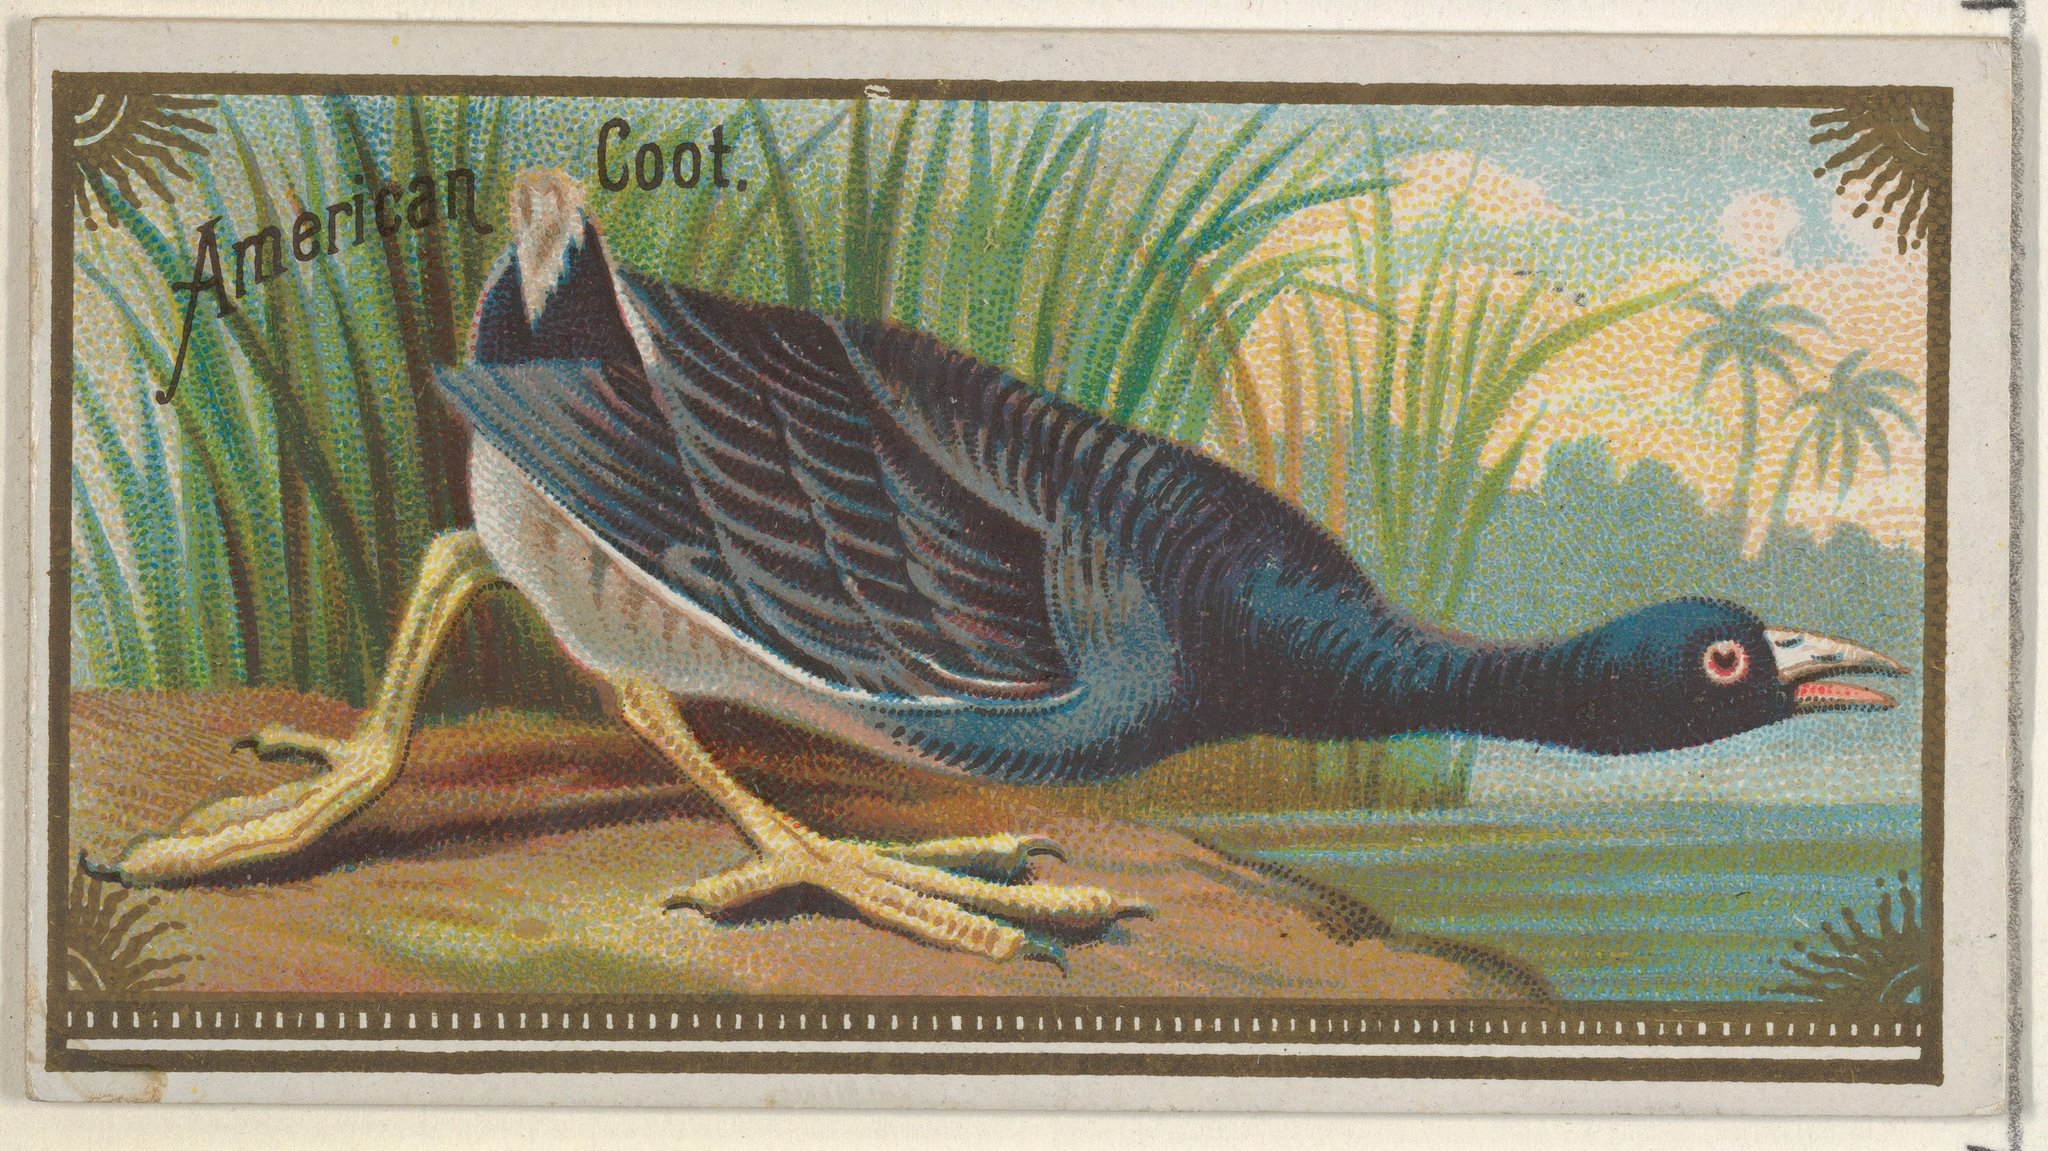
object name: print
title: American Coot, from the Game Birds series (N13) for Allen & Ginter Cigarettes Brands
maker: allen & ginter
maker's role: publisher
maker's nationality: american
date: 1889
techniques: color lithograph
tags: birds